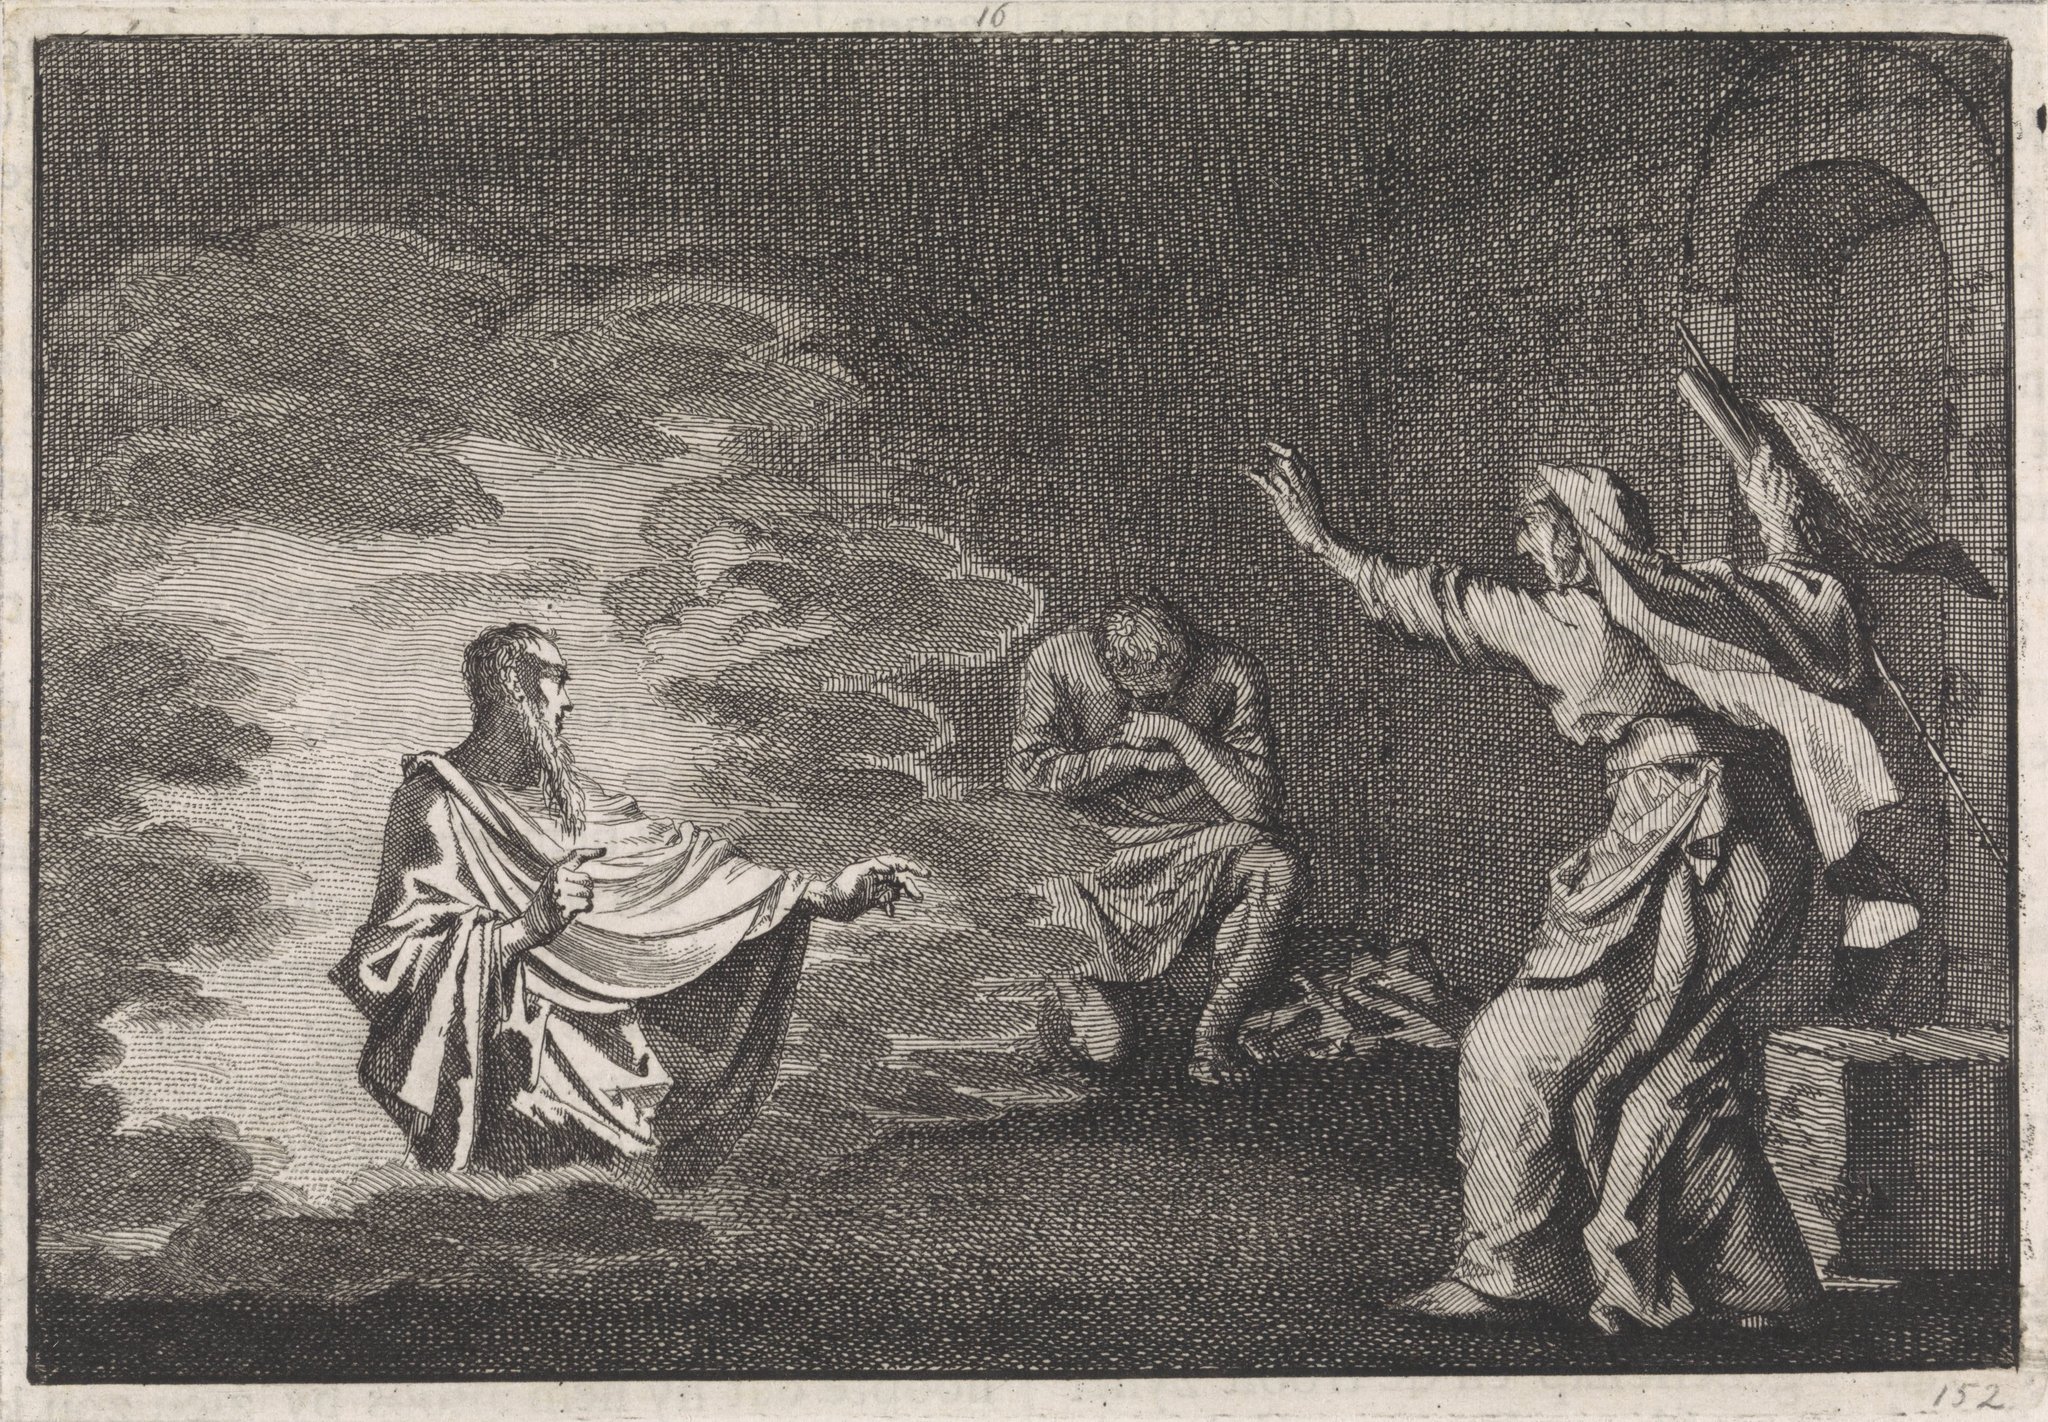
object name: book illustration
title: Saul bij de heks van Endor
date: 1704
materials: paper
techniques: etching, letterpress printing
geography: amsterdam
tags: saul and the witch of endor (1 samuel 28:3-25)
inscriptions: collector's mark: Lugt 2228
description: Prent opgenomen in: Josephus, Flavius. Alle de Werken, 2 delen. Amsterdam: Pieter Mortier, 1704, dl. 1, p. 152.